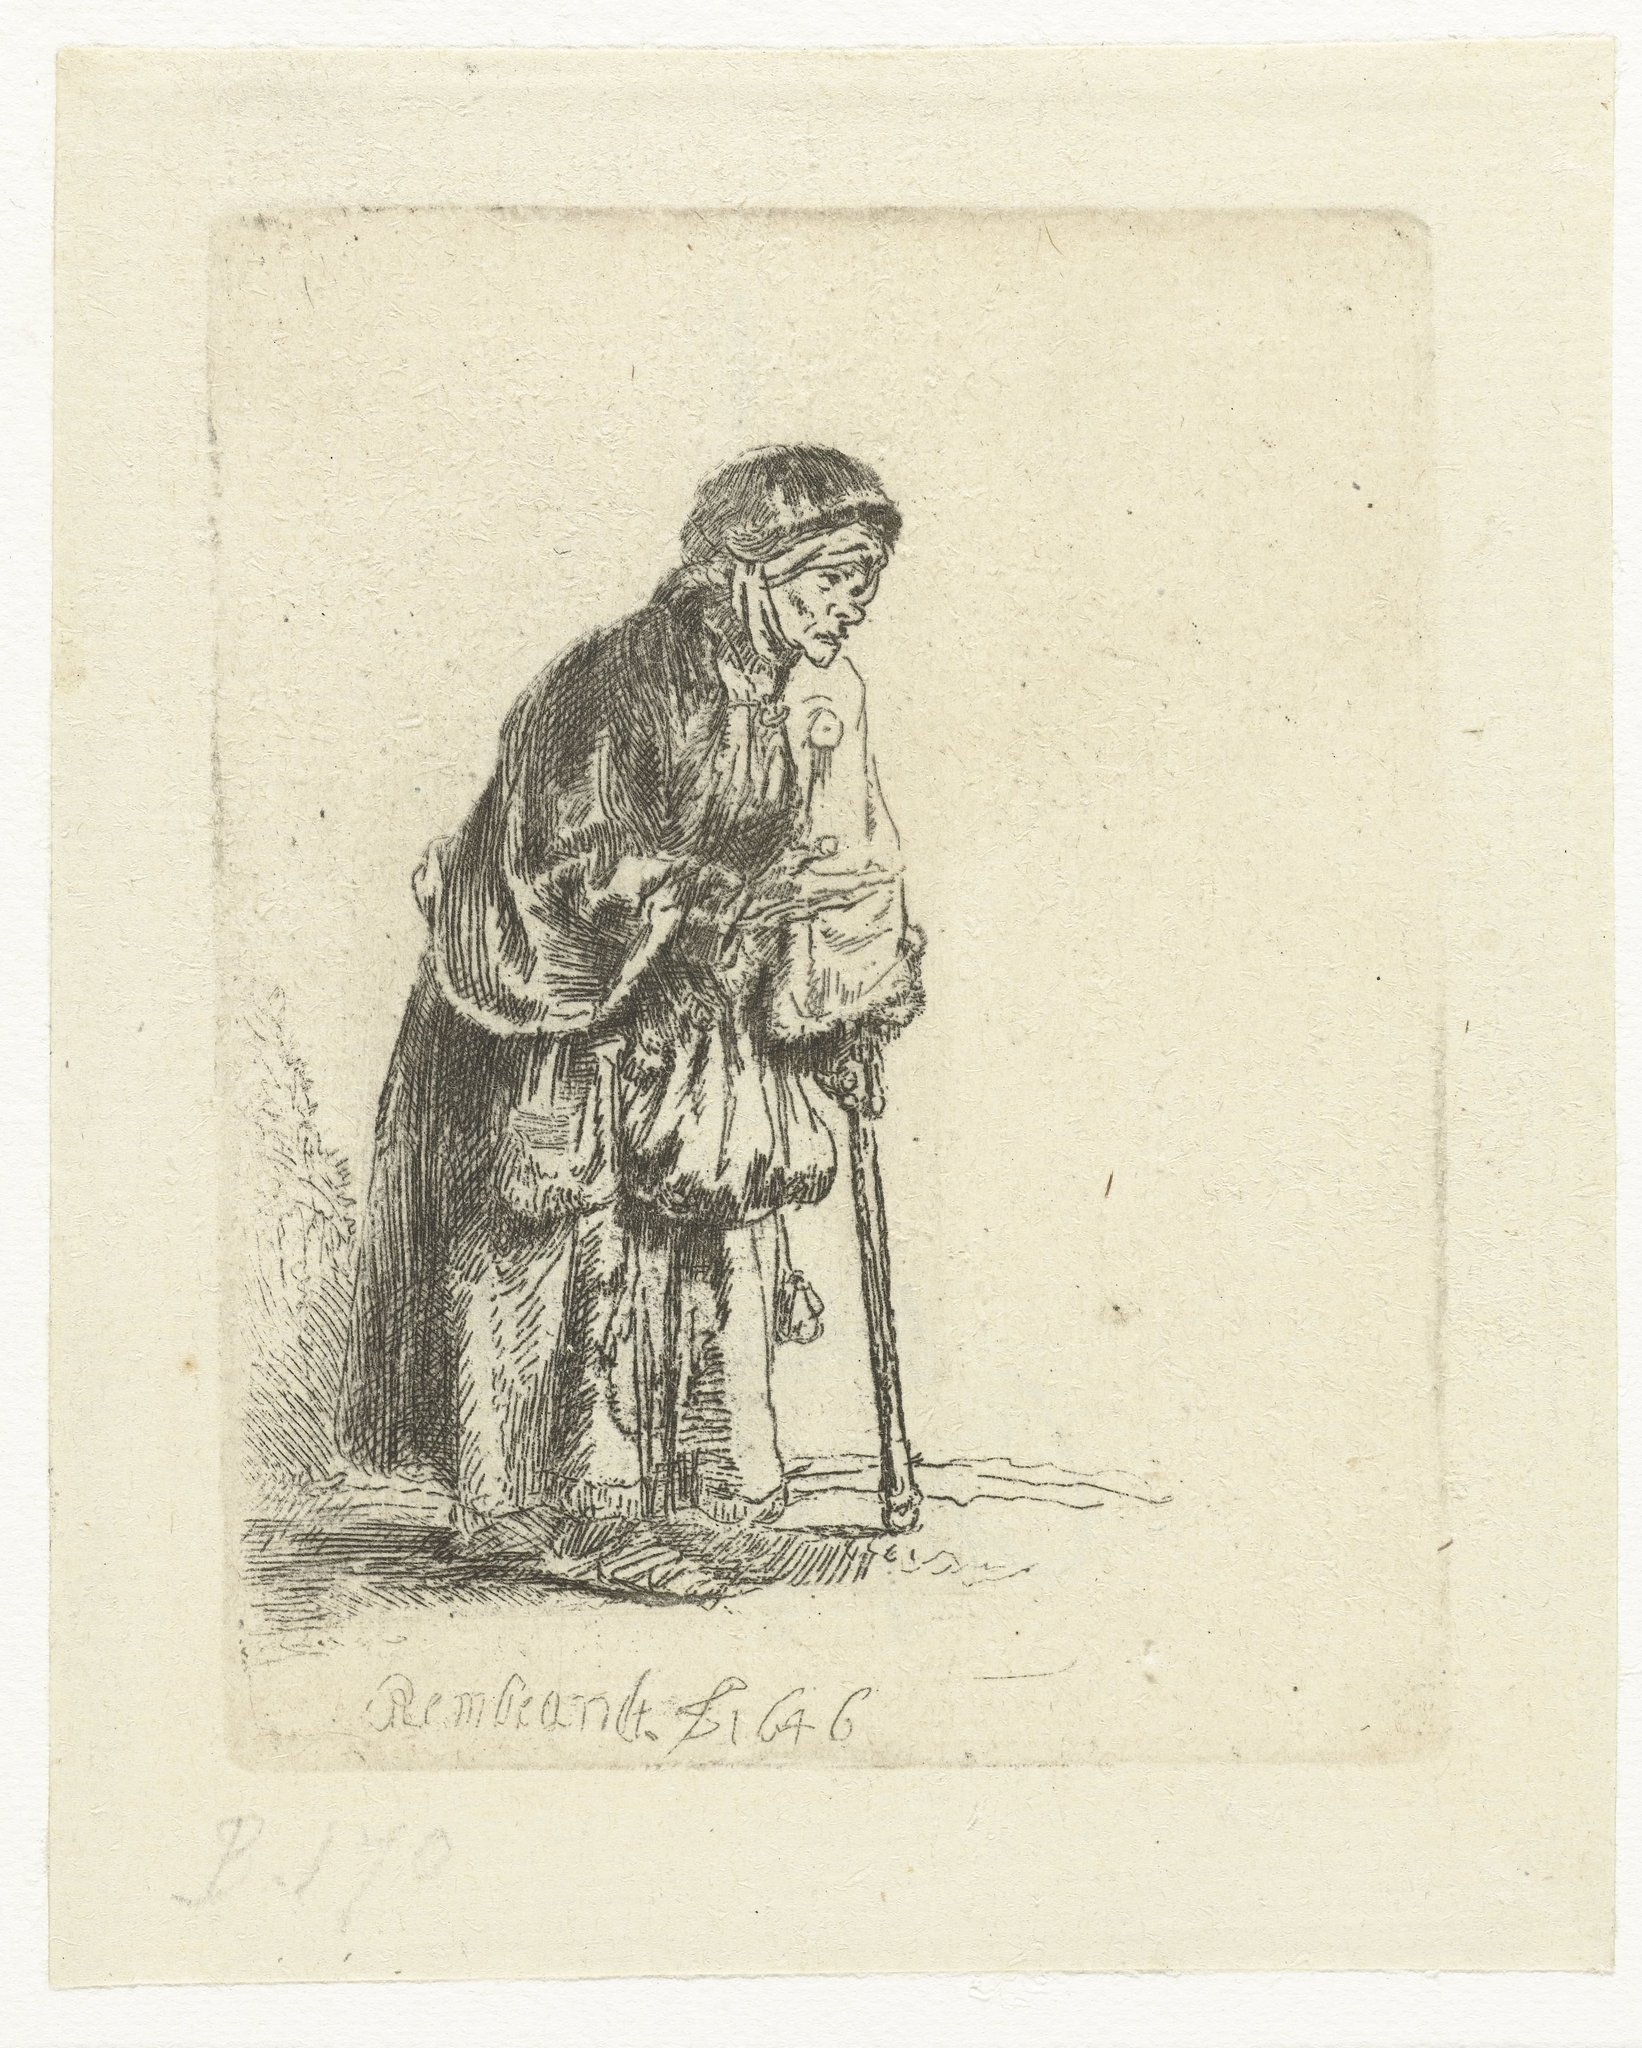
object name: print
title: Beggar woman leaning on a stick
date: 1646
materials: paper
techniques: drypoint, etching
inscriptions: inscription: ‘Coppier’, signature and date: ‘Rembrandt f. 1646’